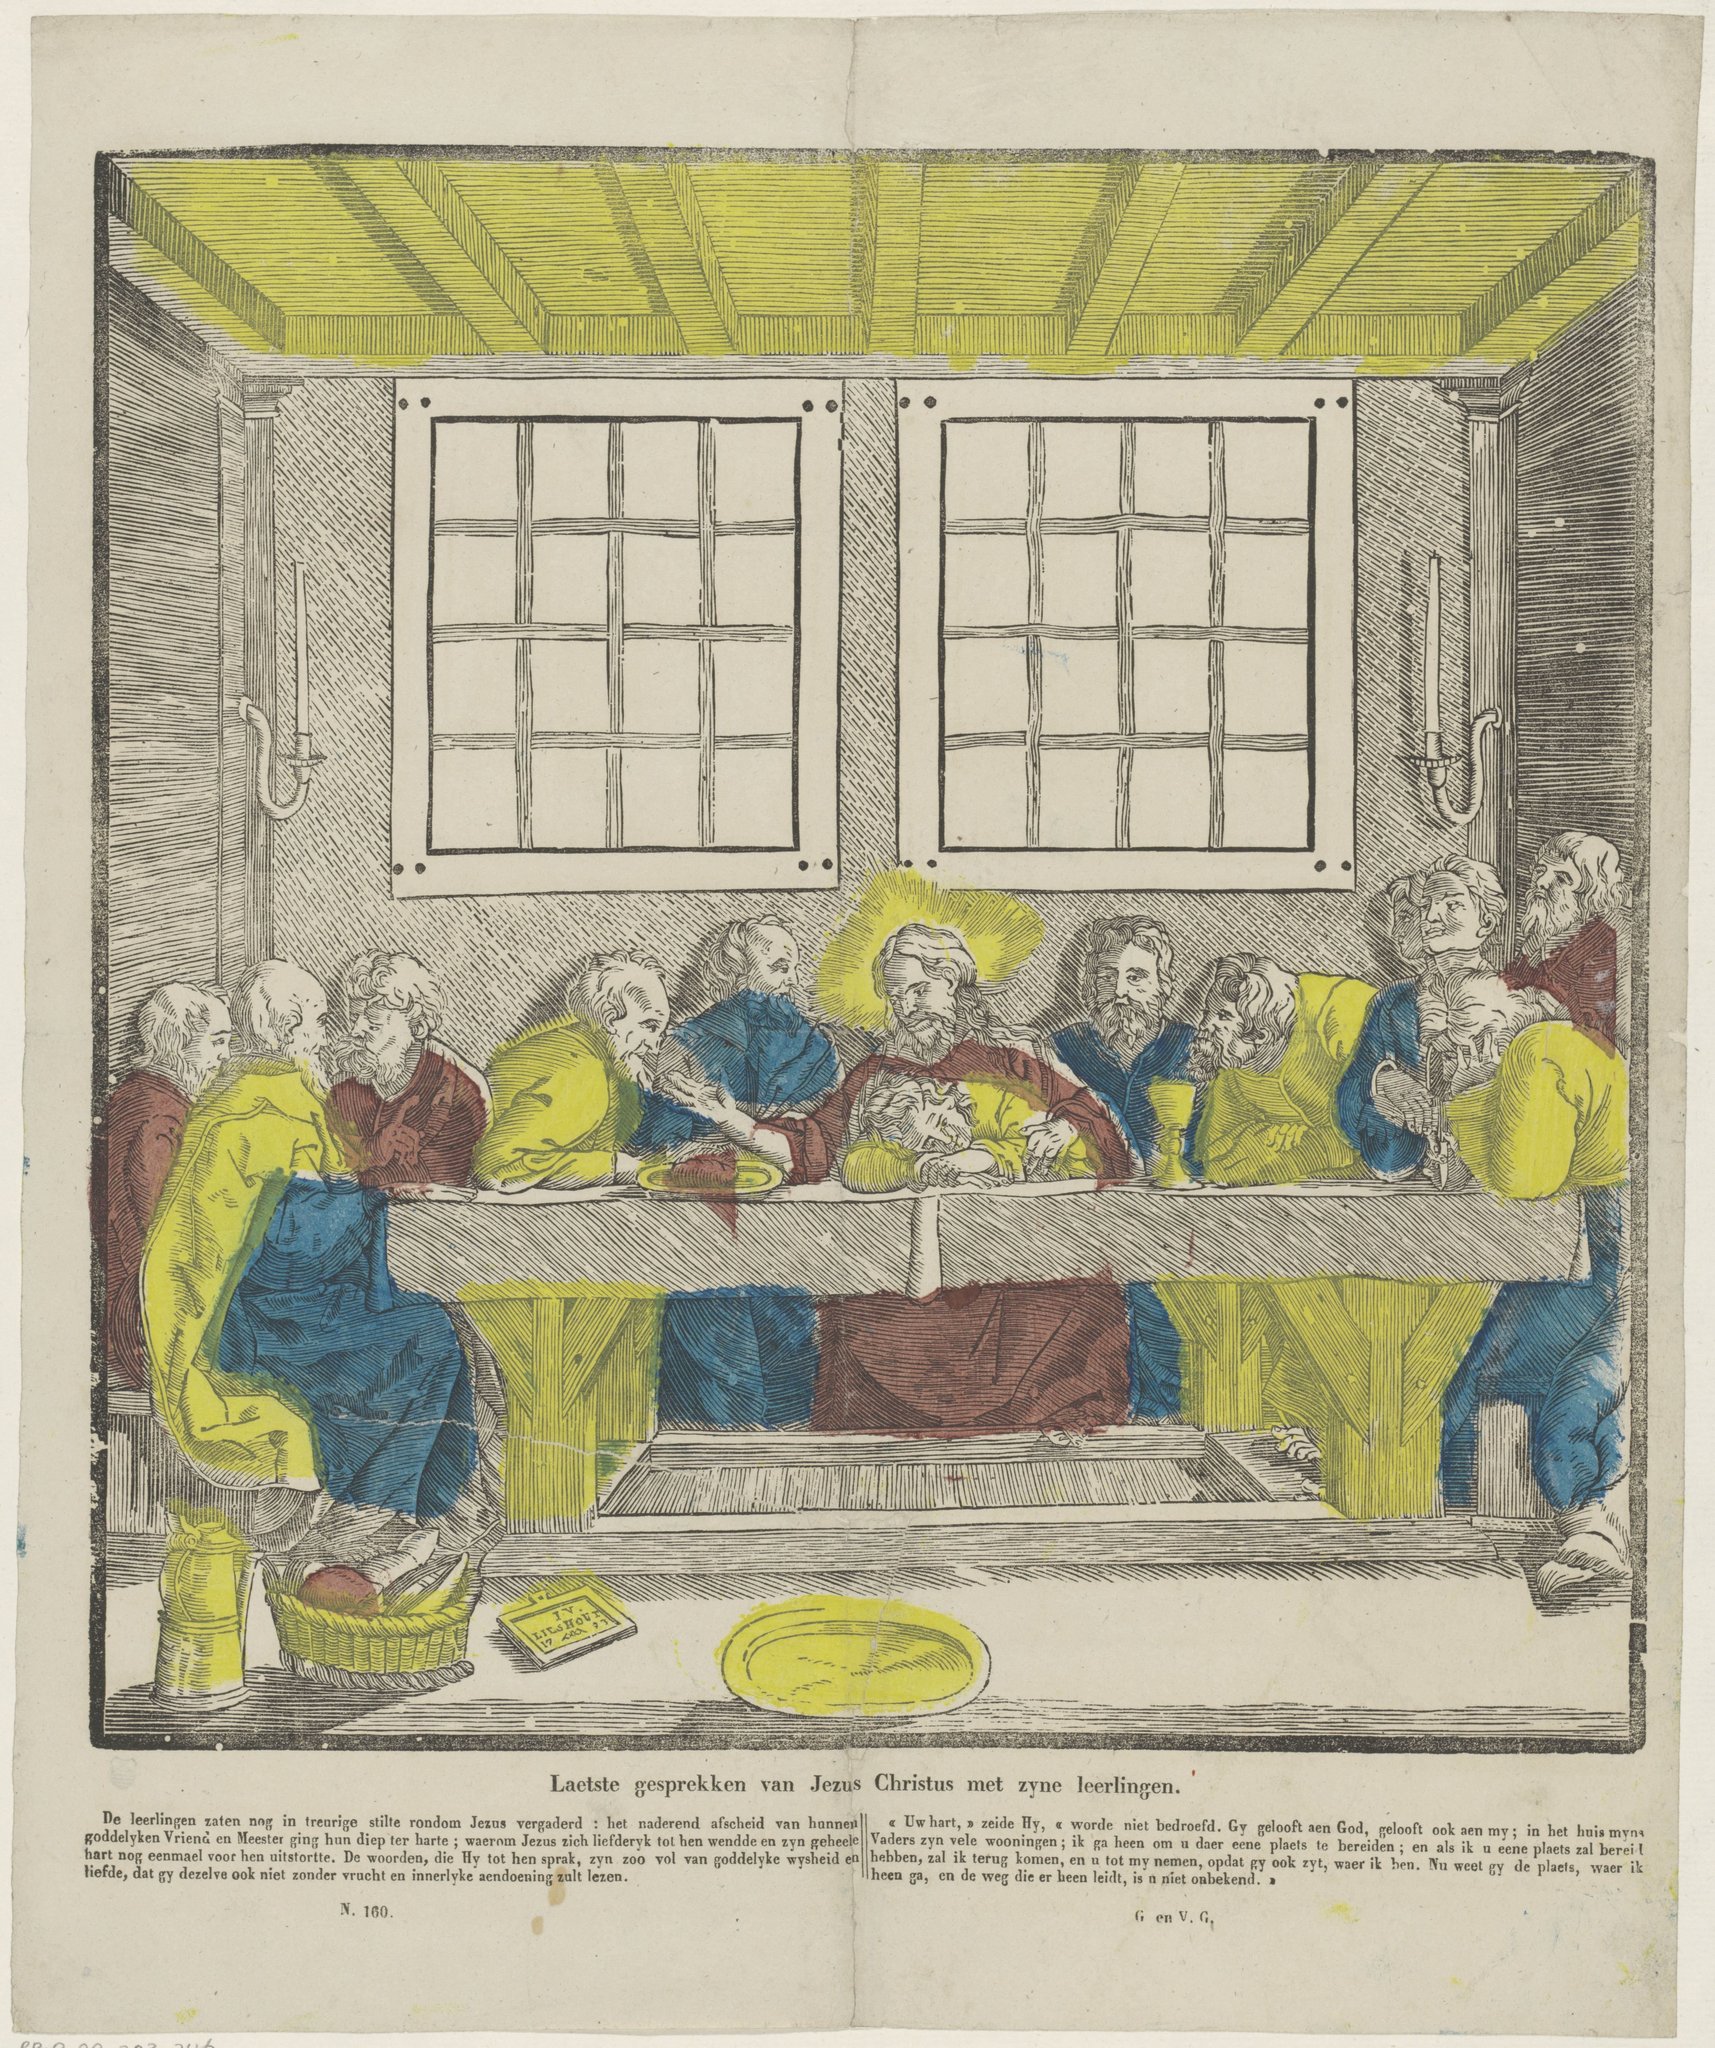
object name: print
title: Laetste gesprekken van Jezus Christus met zyne leerlingen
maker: johannes egbertus van lieshout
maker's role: print maker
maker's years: 1770-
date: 1773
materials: paper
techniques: colour, letterpress printing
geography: turnhout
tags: the episode of the last supper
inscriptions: collector's mark: Lugt 2760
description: Blad met een grote voorstelling van het Laatste Avondmaal. In de ondermarge een onderschrift in twee kolommen. Genummerd linksonder: N. 160.